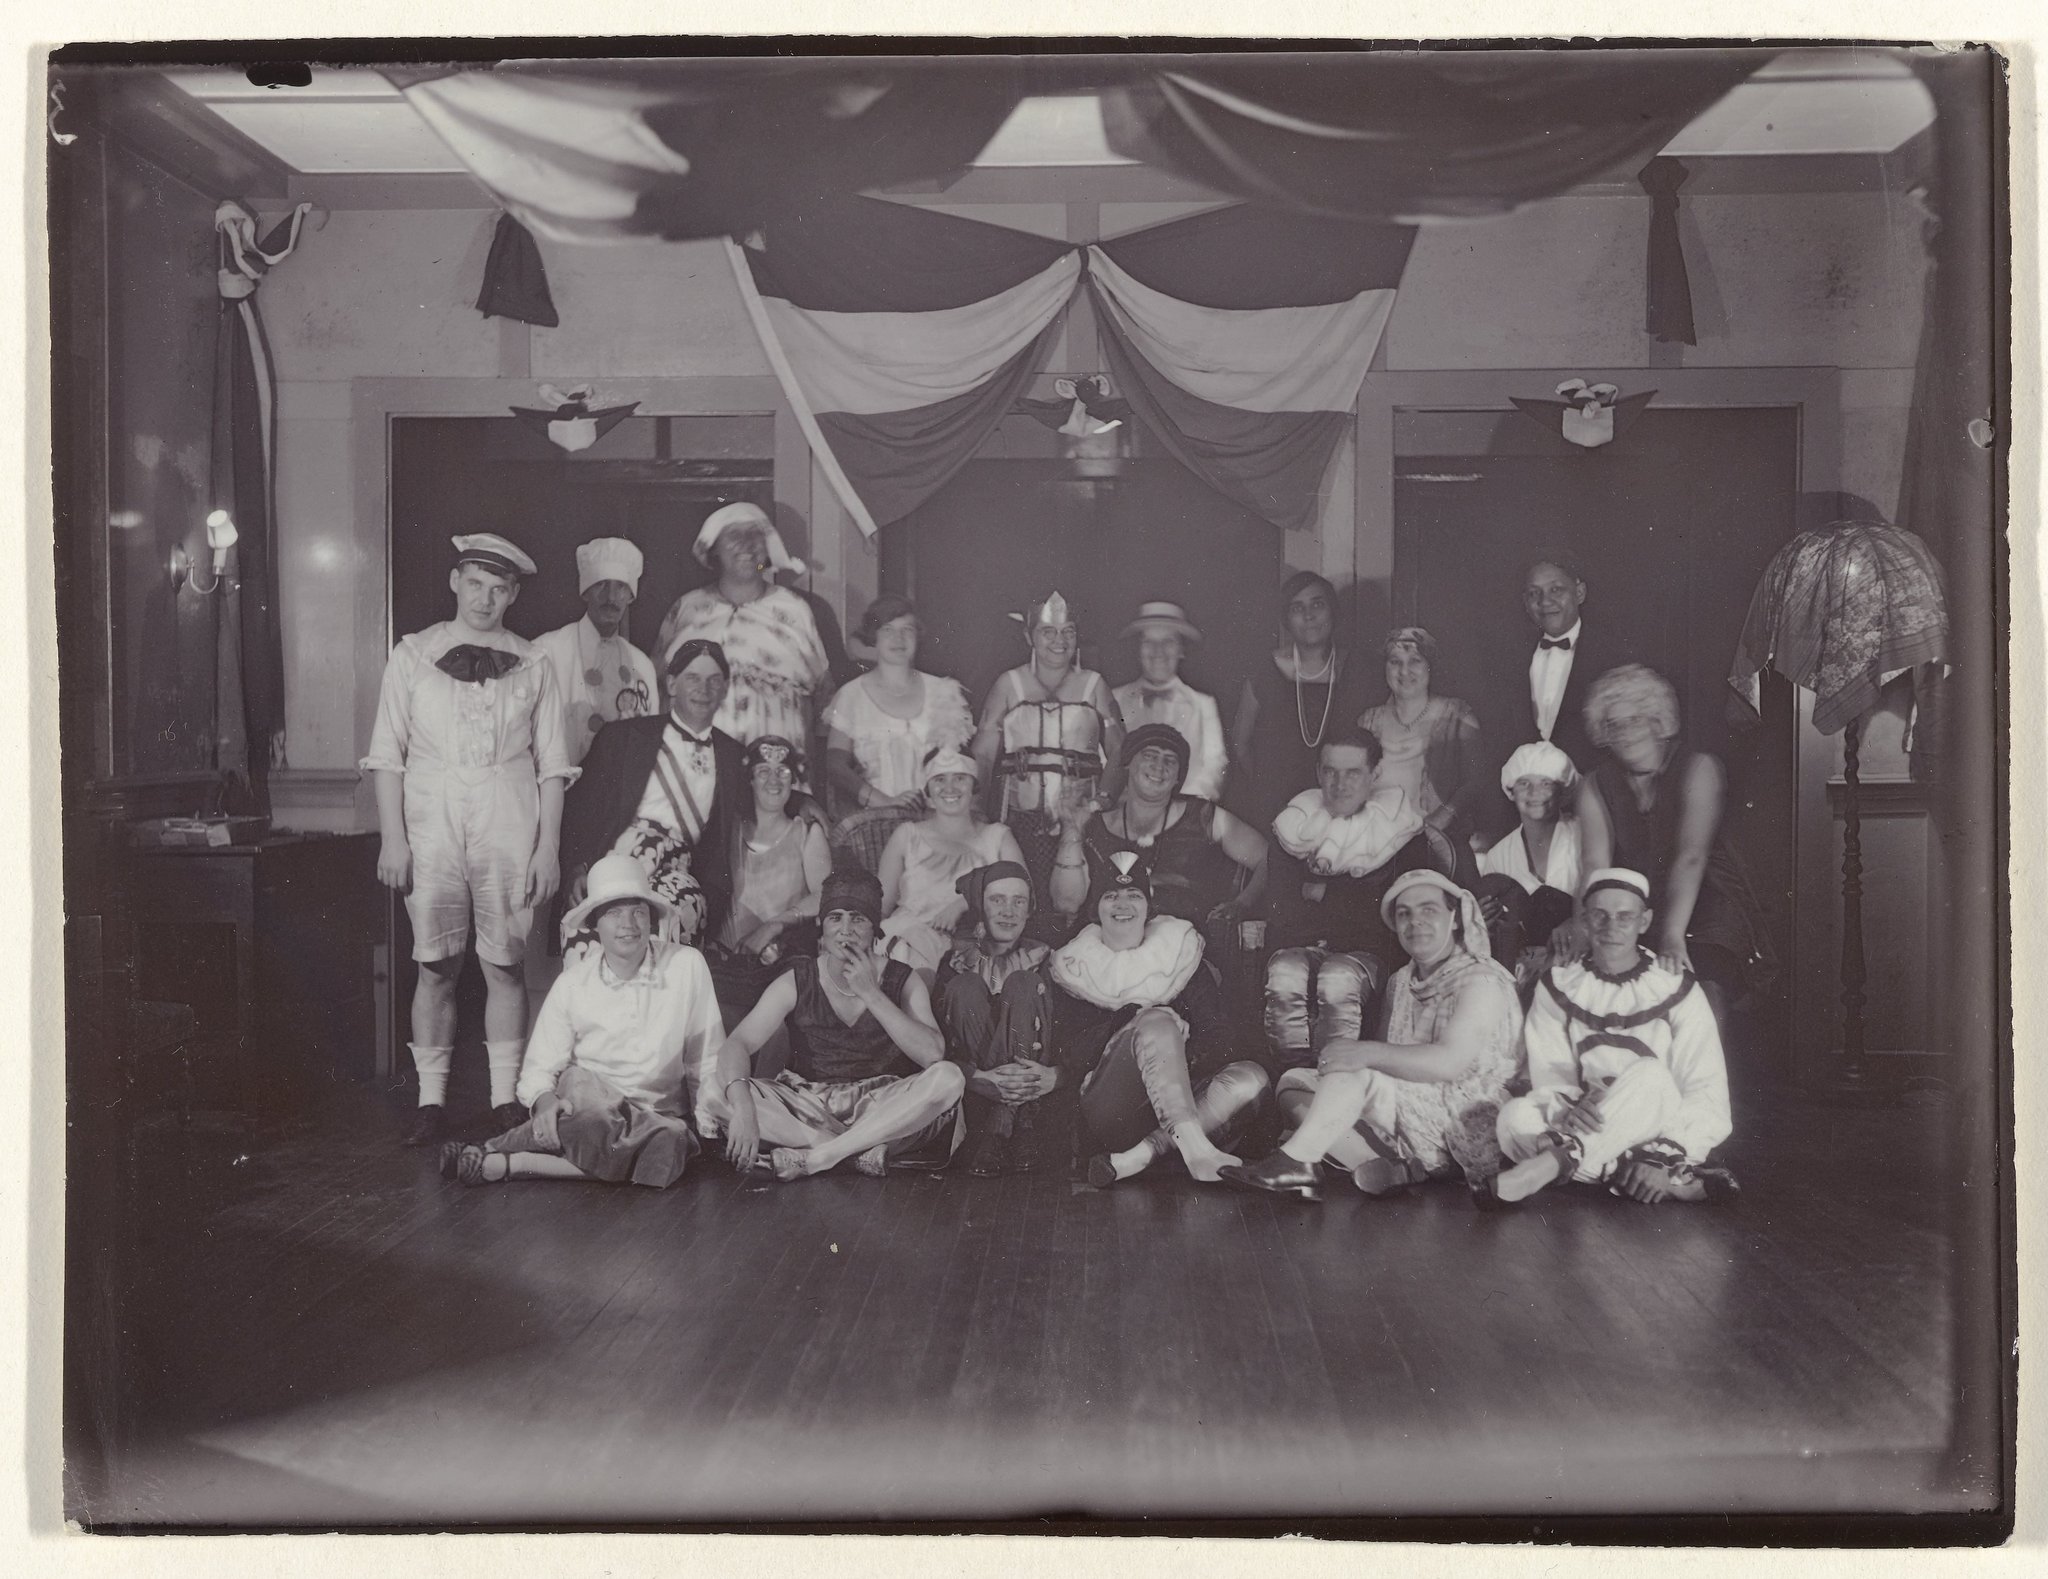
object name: photograph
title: Feest in Moengo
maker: Anonymous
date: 1929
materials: photographic support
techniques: photography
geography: suriname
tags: masquerade, masked ball